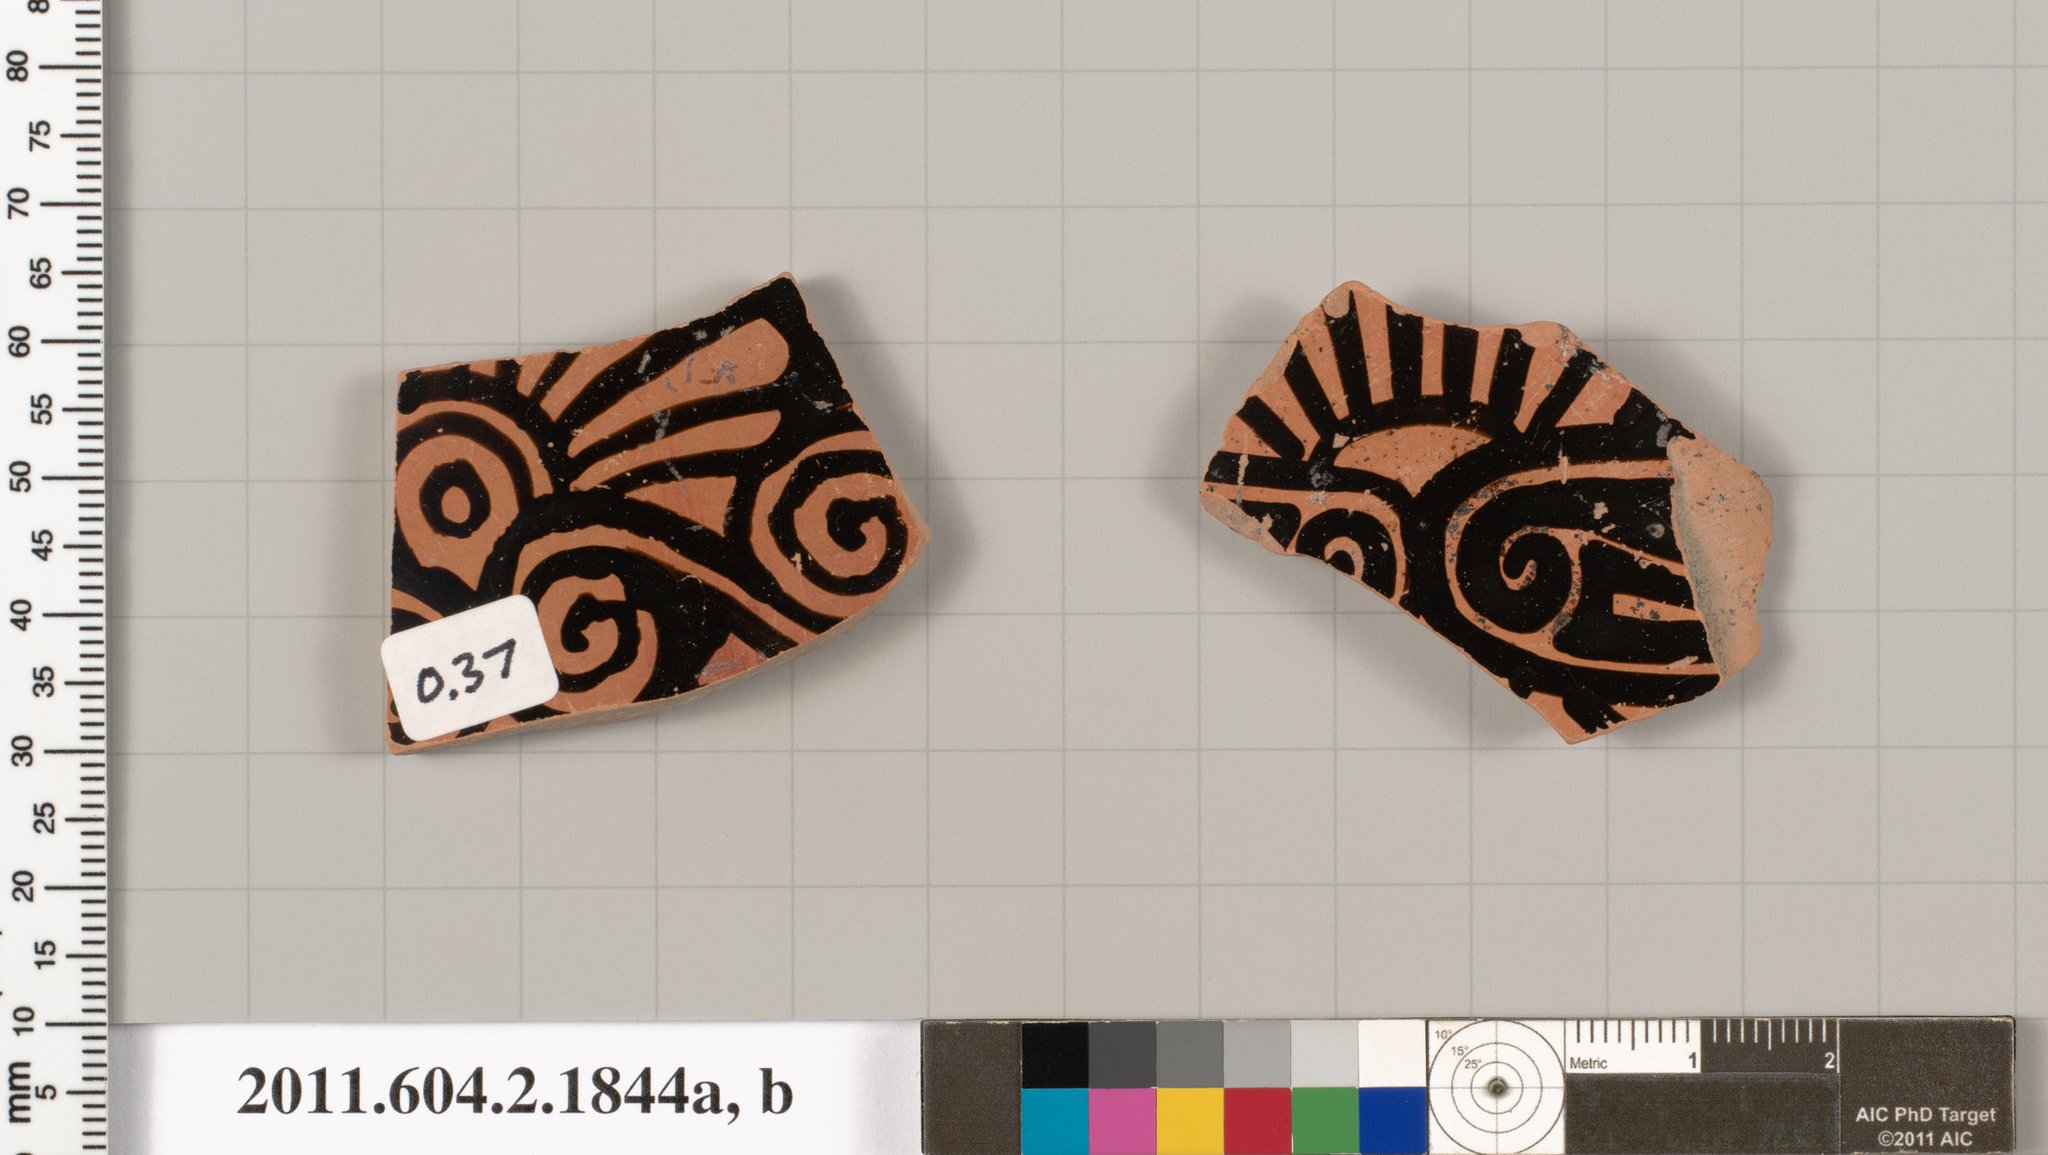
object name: skyphos fragment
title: Terracotta fragments of skyphoi (deep drinking cups)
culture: greek, attic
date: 450-426 BCE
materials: terracotta